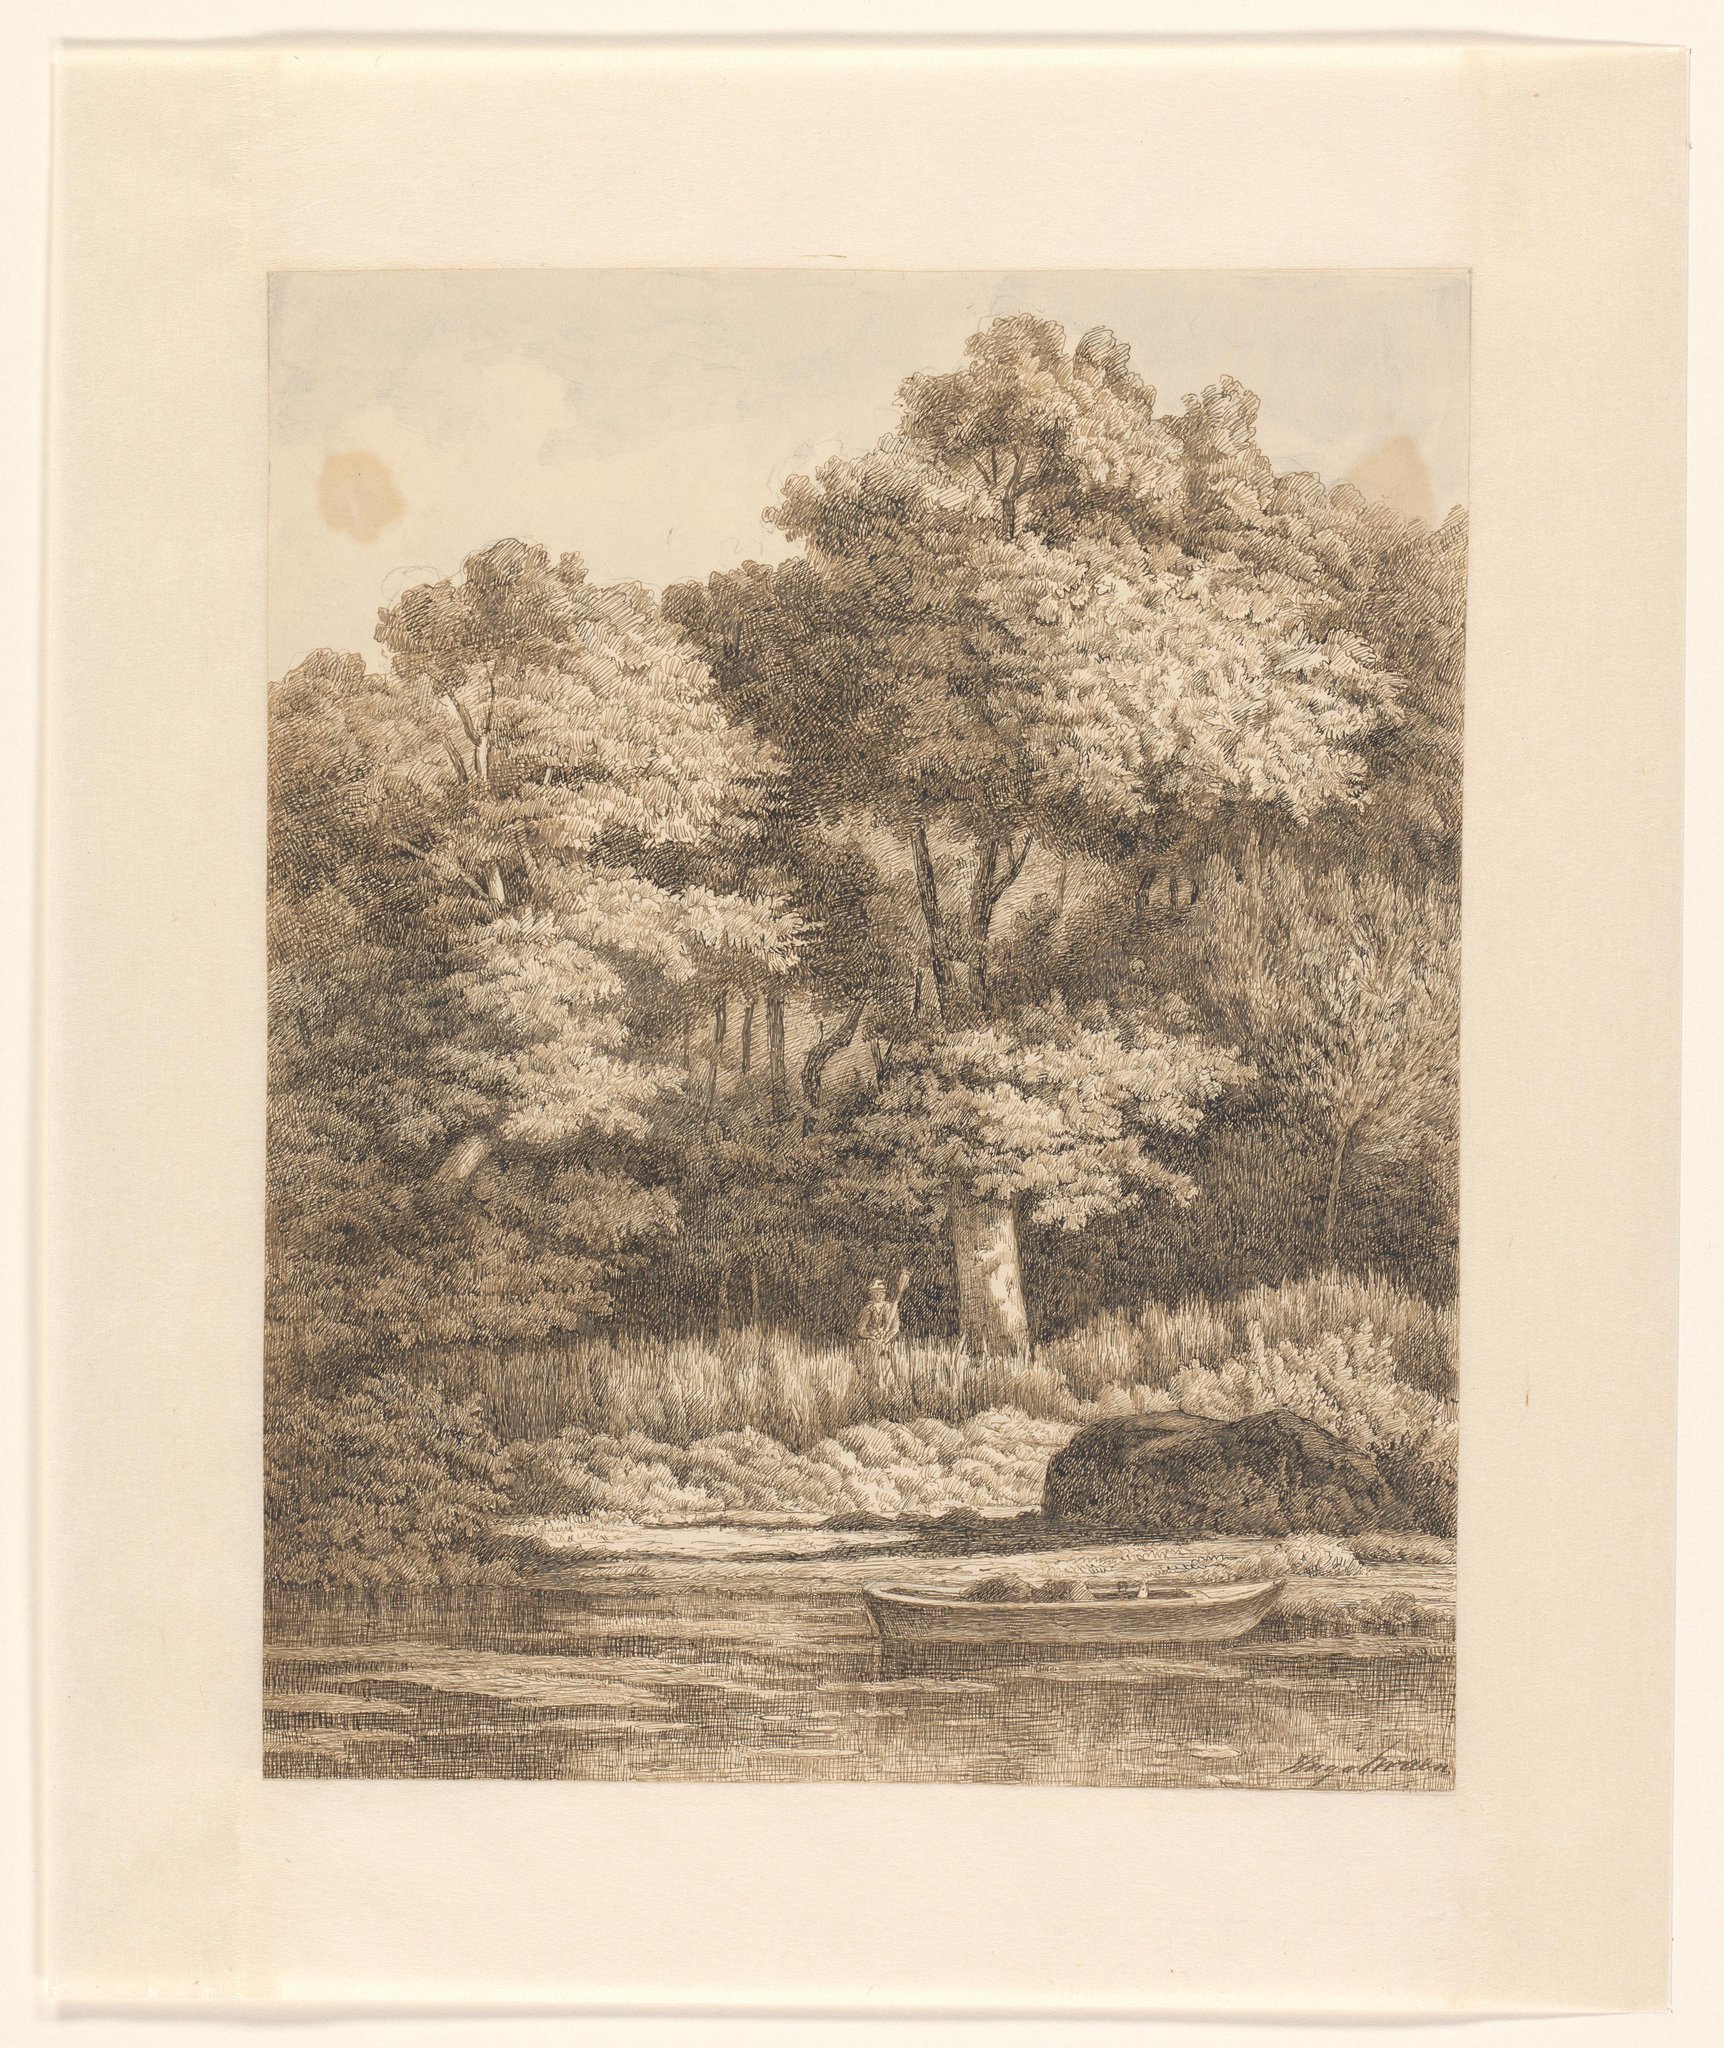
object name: drawing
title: Man aan een waterkant in Overveen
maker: hugo swaen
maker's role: draughtsman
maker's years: 1825-1910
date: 1835-1910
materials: ink, paper, pencil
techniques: brush, pen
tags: landscapes with waters, waterscapes, seascapes (in the temperate zone), rowing-boat, canoe, etc.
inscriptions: name: ‘Hugo Swaen’, inscription: ‘no. 125./ Naar eene studie/ achter 't Kolkje/ te Overveen.’